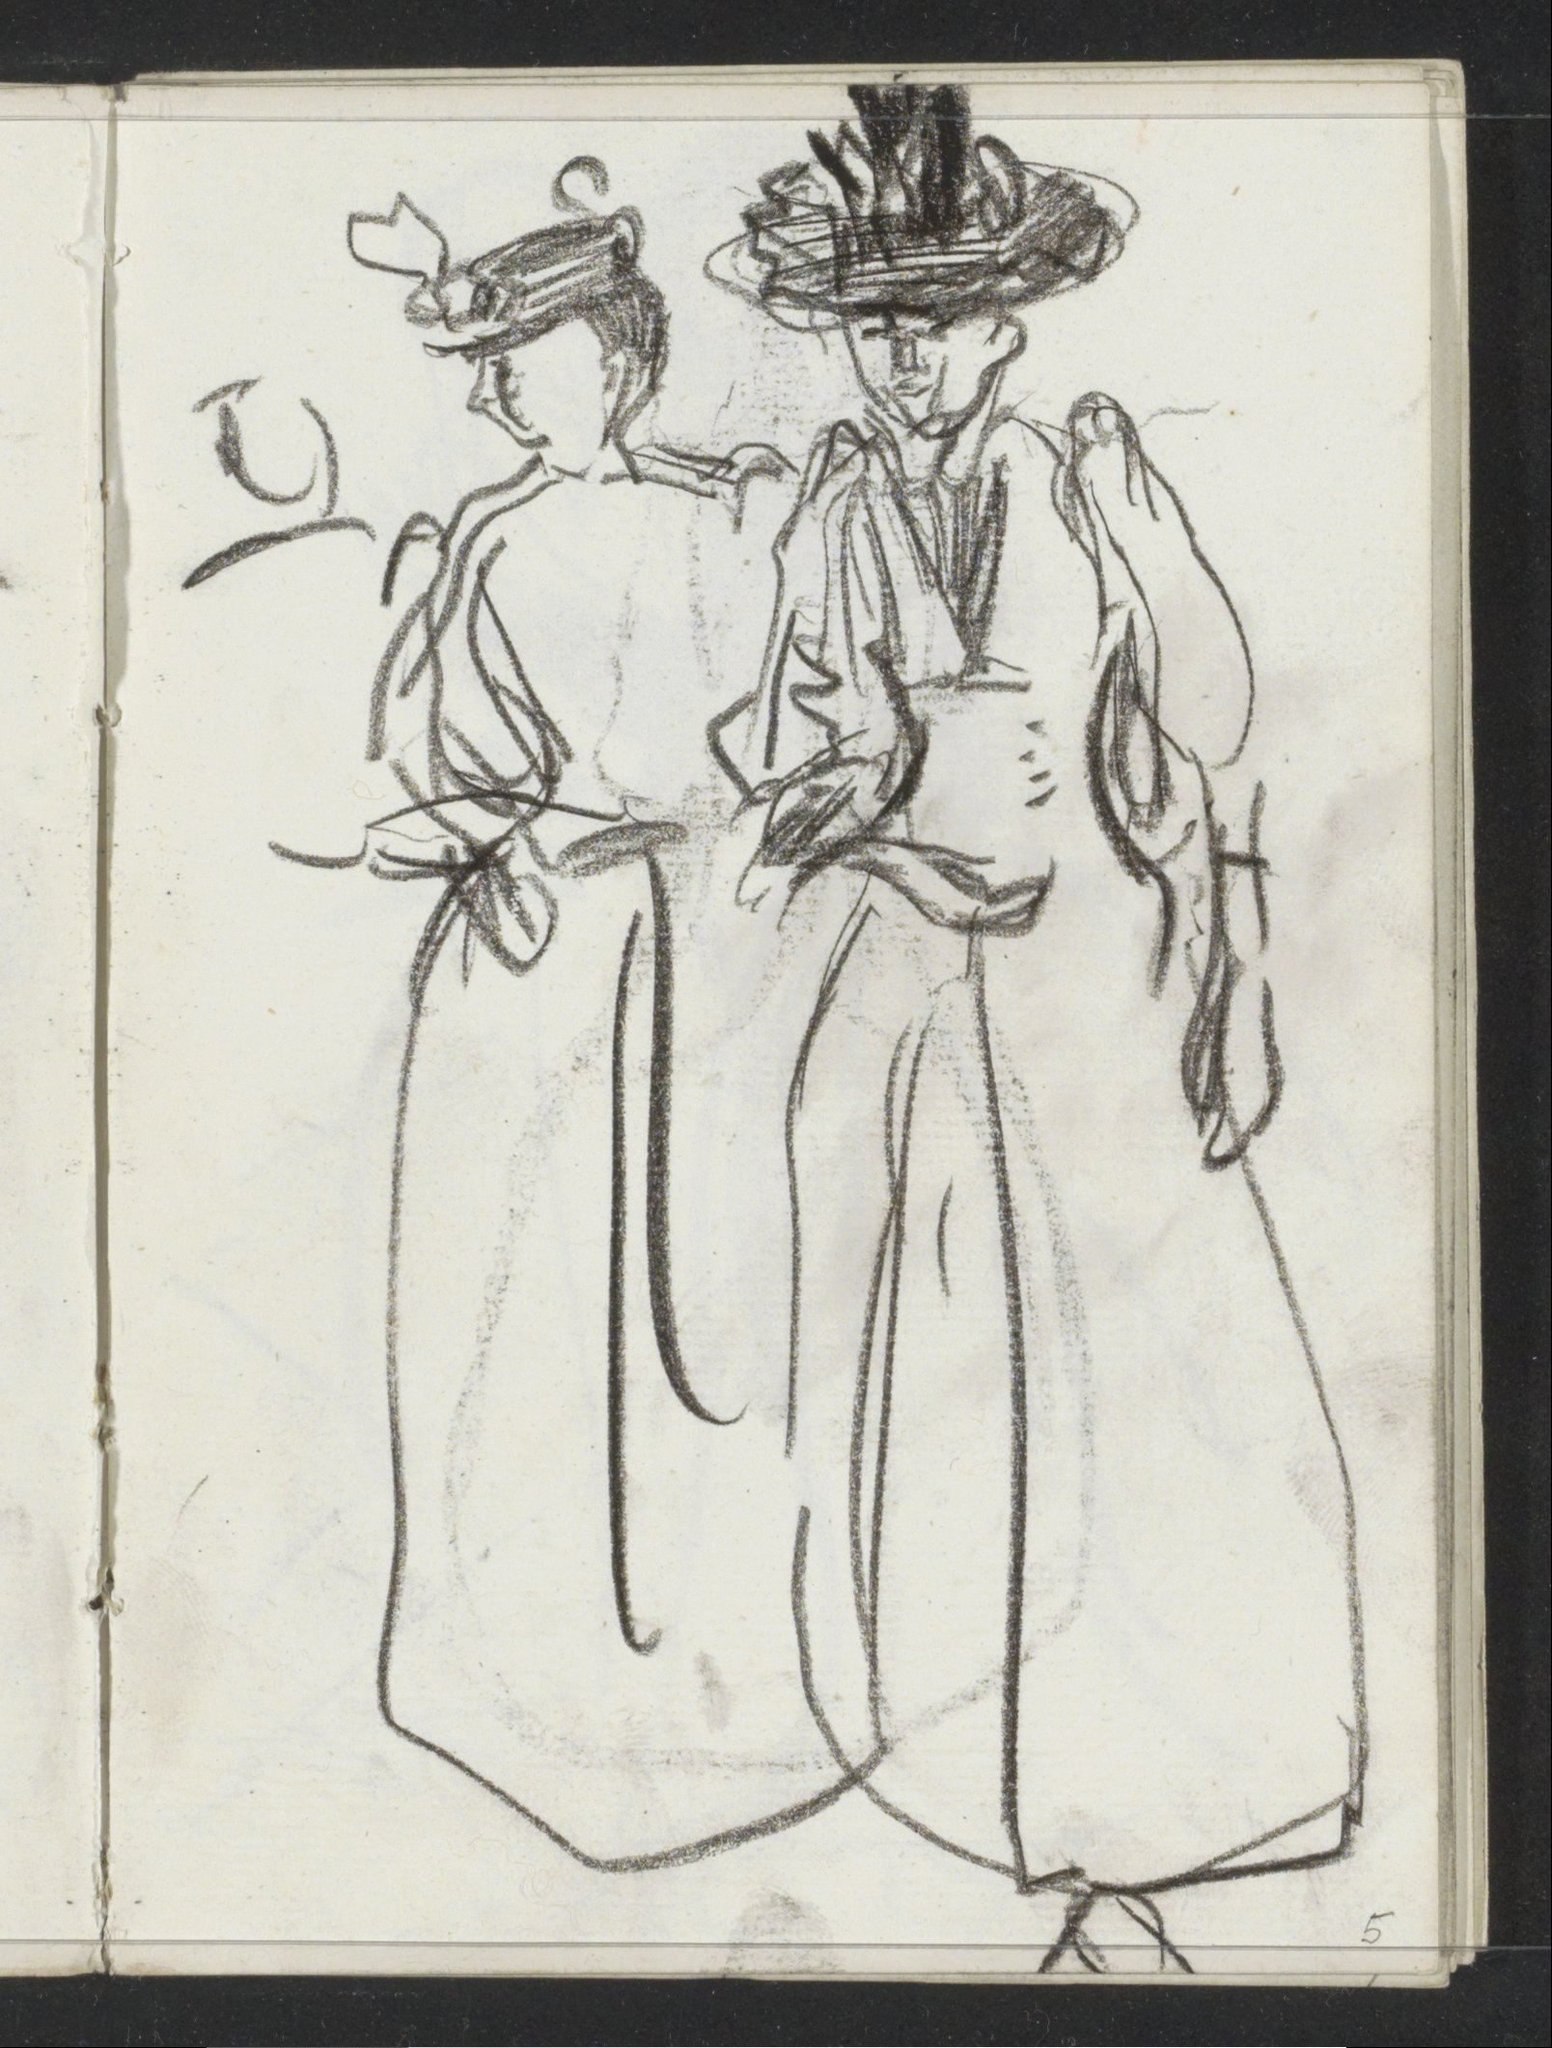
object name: sketchbook leaf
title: Twee staande vrouwen met hoed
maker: isaac israels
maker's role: draughtsman, painter, print maker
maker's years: 1865-1934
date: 1886-1934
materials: chalk, paper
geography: amsterdam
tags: head-gear: hat (+ women's clothes), adult woman (+ standing)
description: Blad 5 recto uit schetsboek LXIII met 23 bladen.